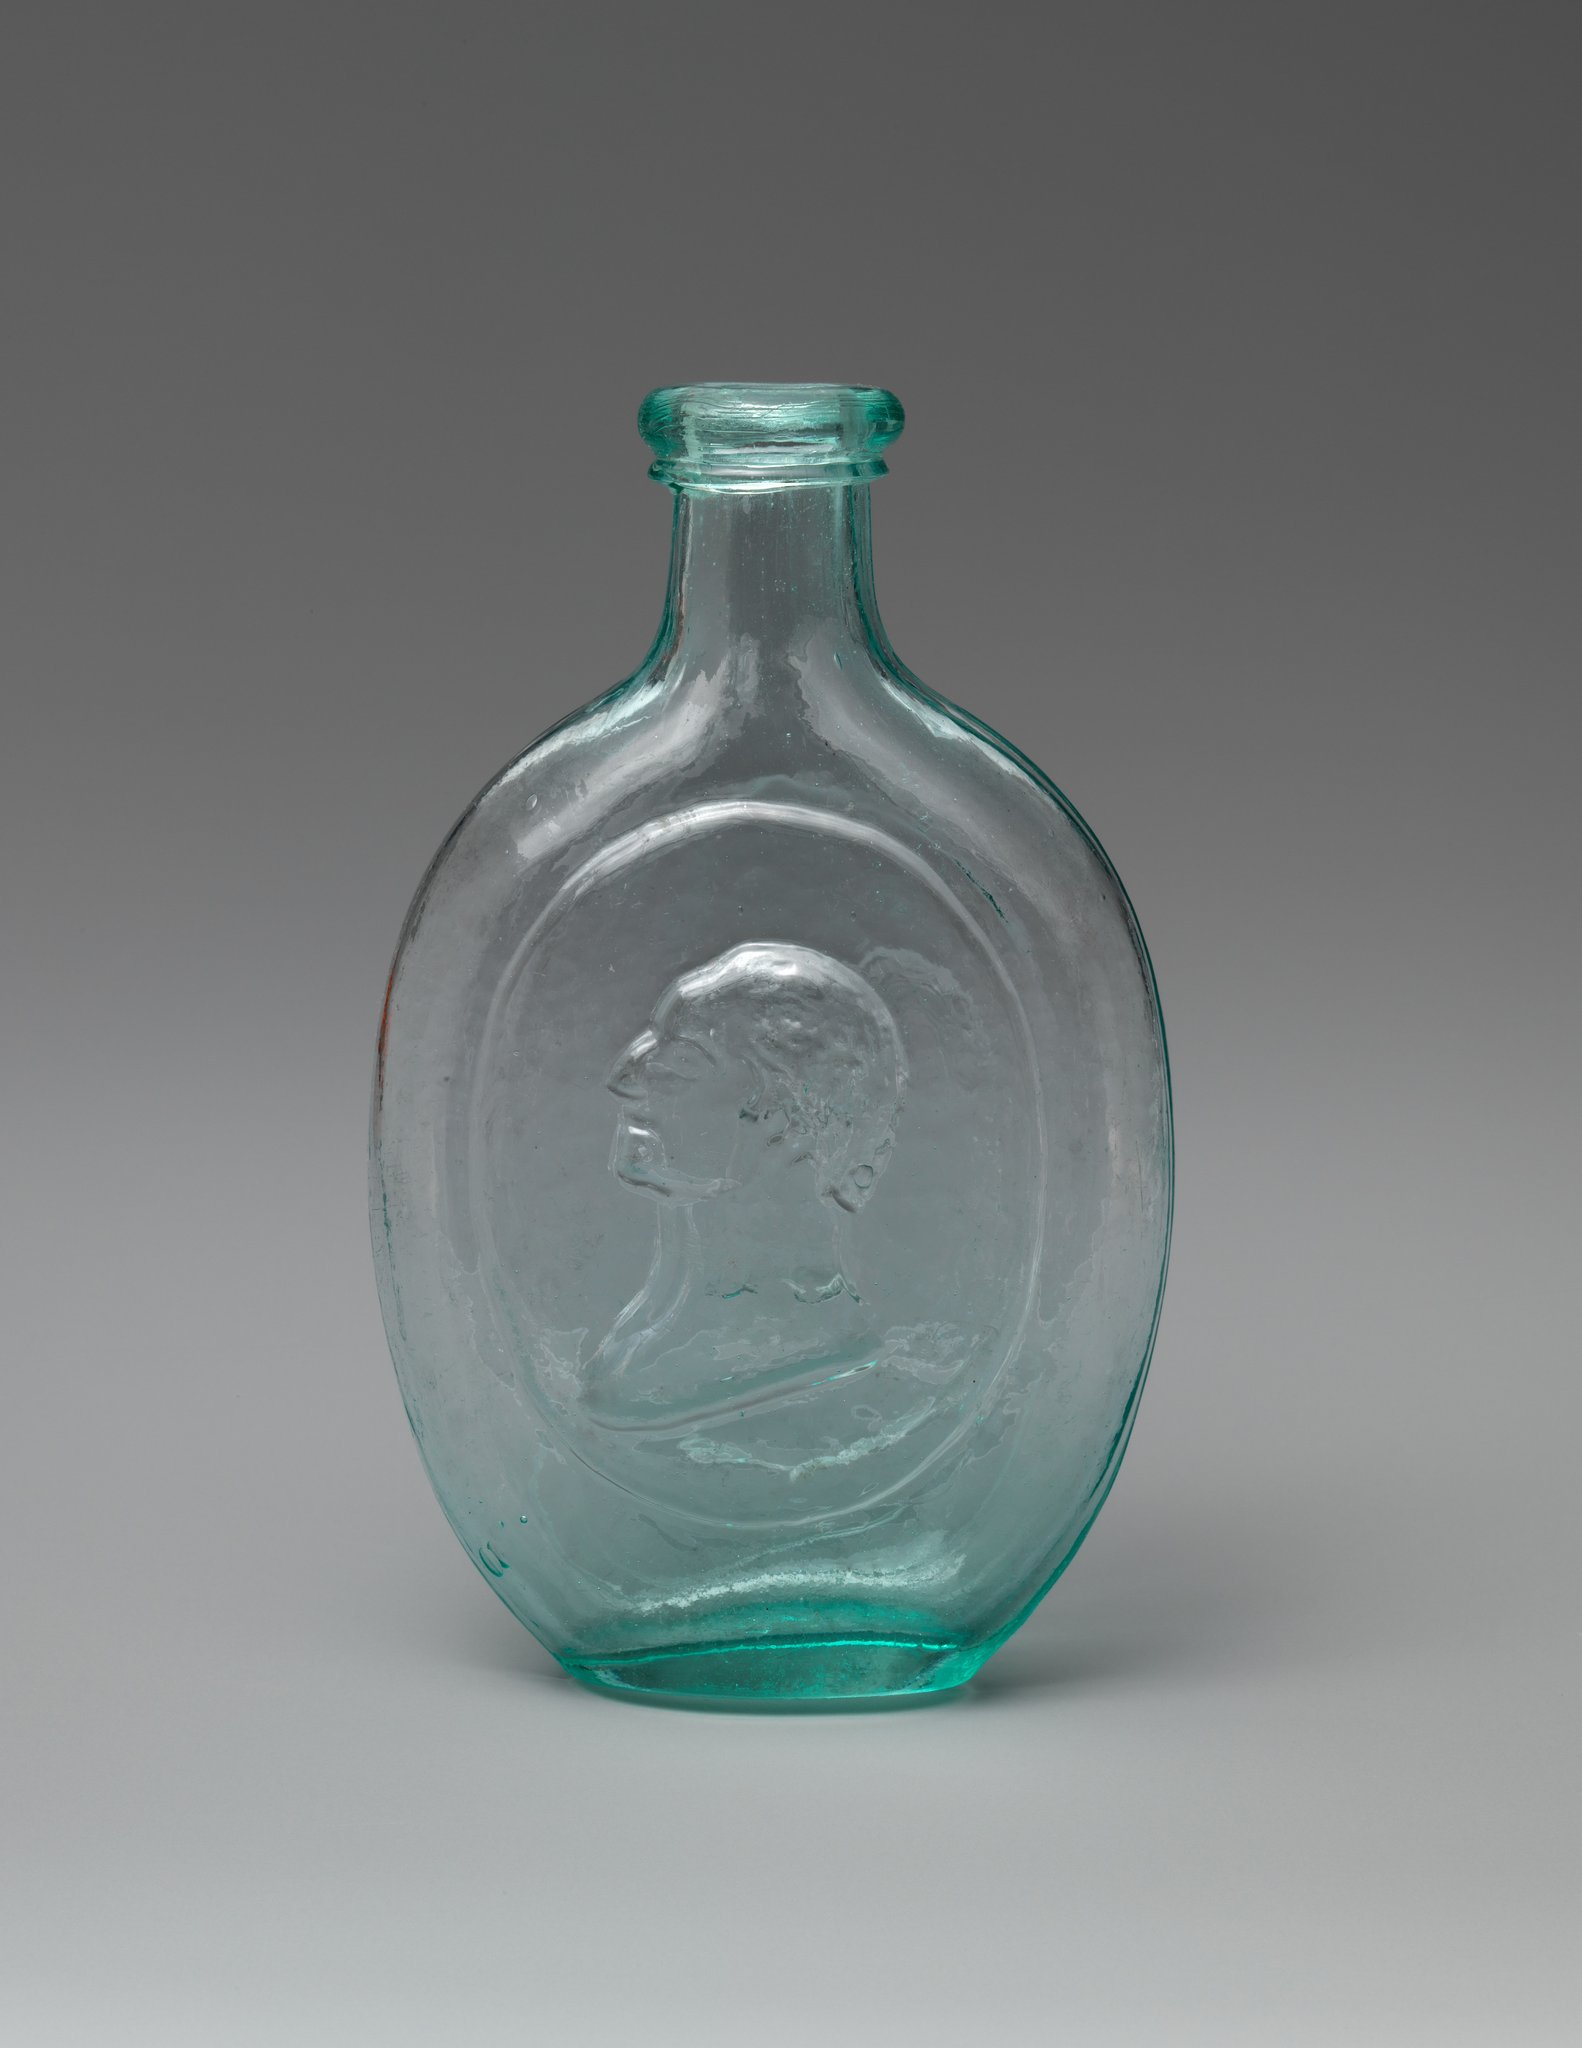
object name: flask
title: Half-pint flask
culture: american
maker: dyottville glass works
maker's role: manufacturer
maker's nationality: american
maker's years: 1833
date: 1830-1838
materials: glass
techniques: glassblowing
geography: united states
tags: george washington,men